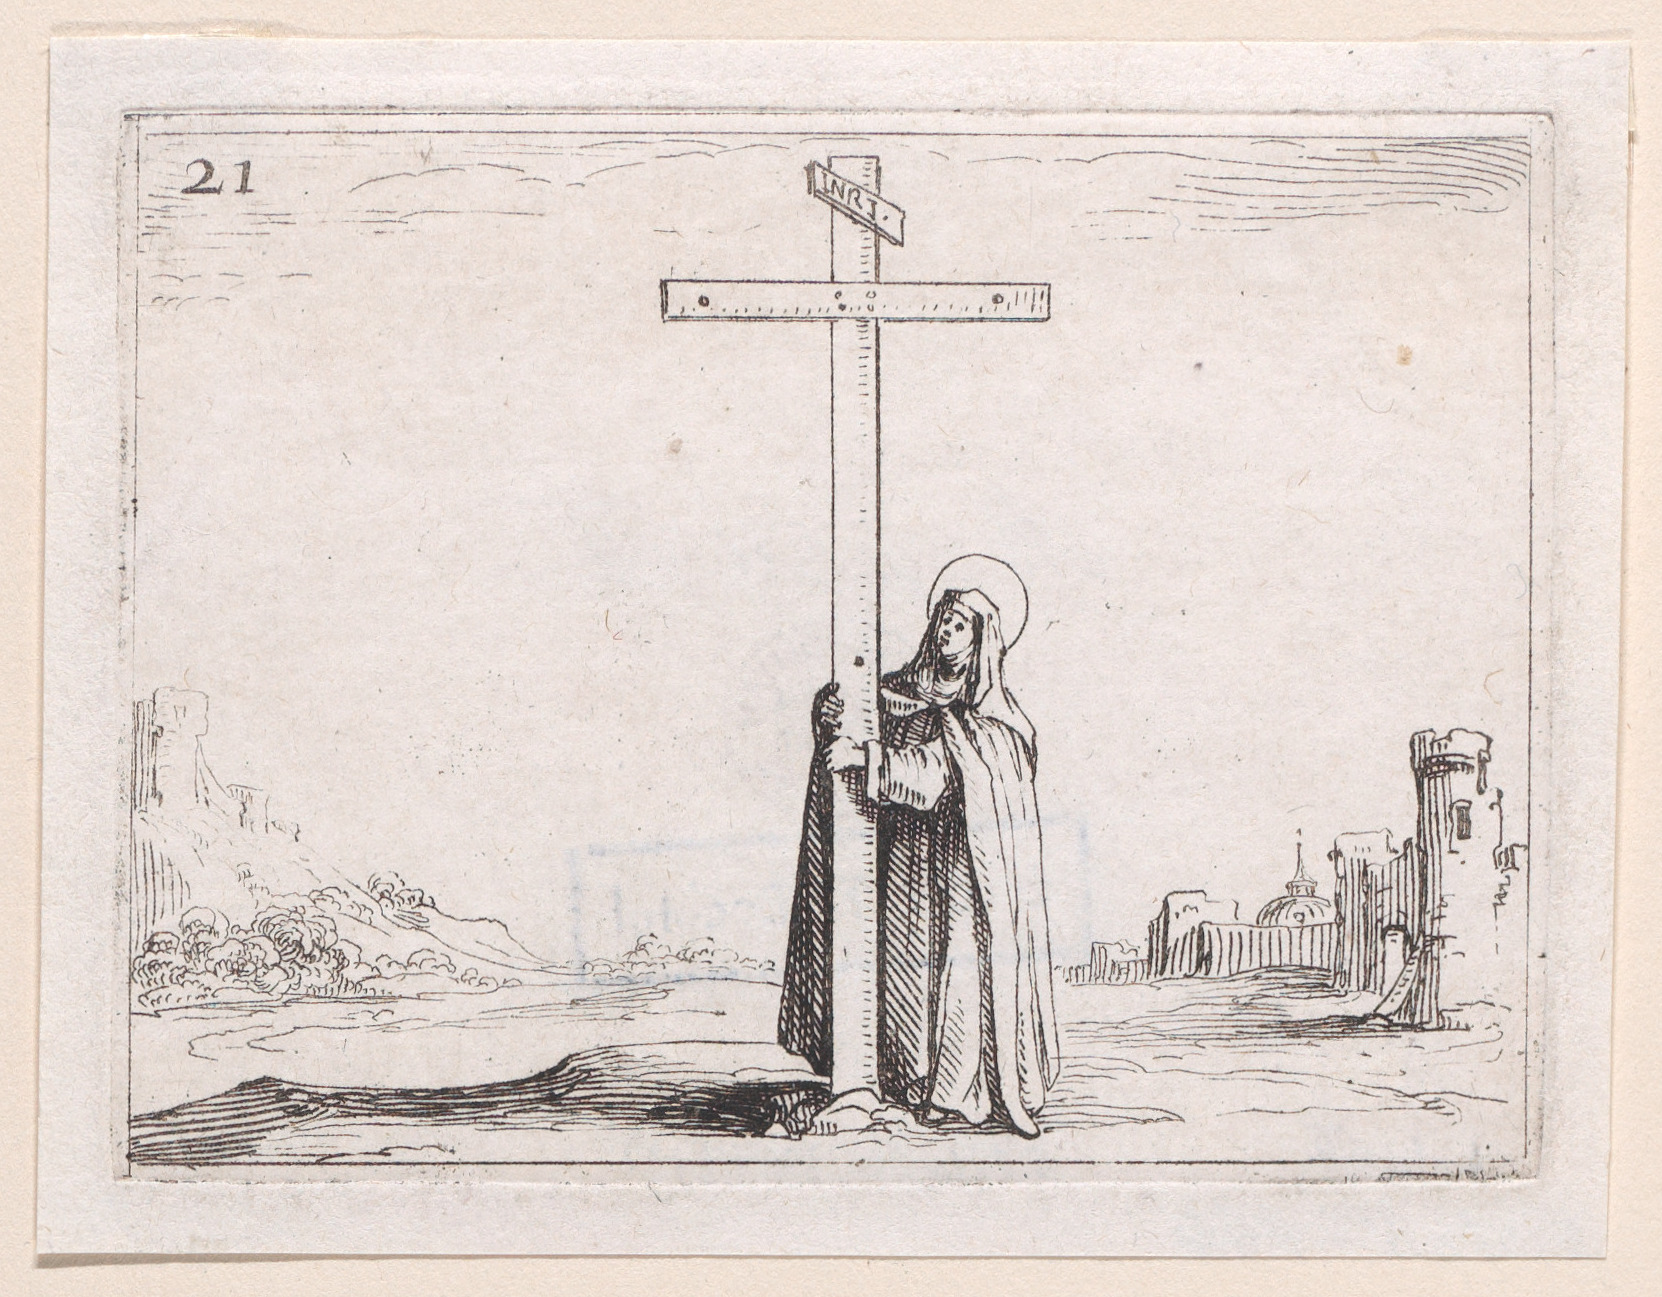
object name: print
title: La Religieuse Tenant La Sainte Croix (The Nun Holds the Cross), plate 21 from "Lux Claustri ou La Lumière du Cloitre" (The Light of the Cloisters)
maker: jacques callot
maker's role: artist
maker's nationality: french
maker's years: 1592-1635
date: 1621-1635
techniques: etching